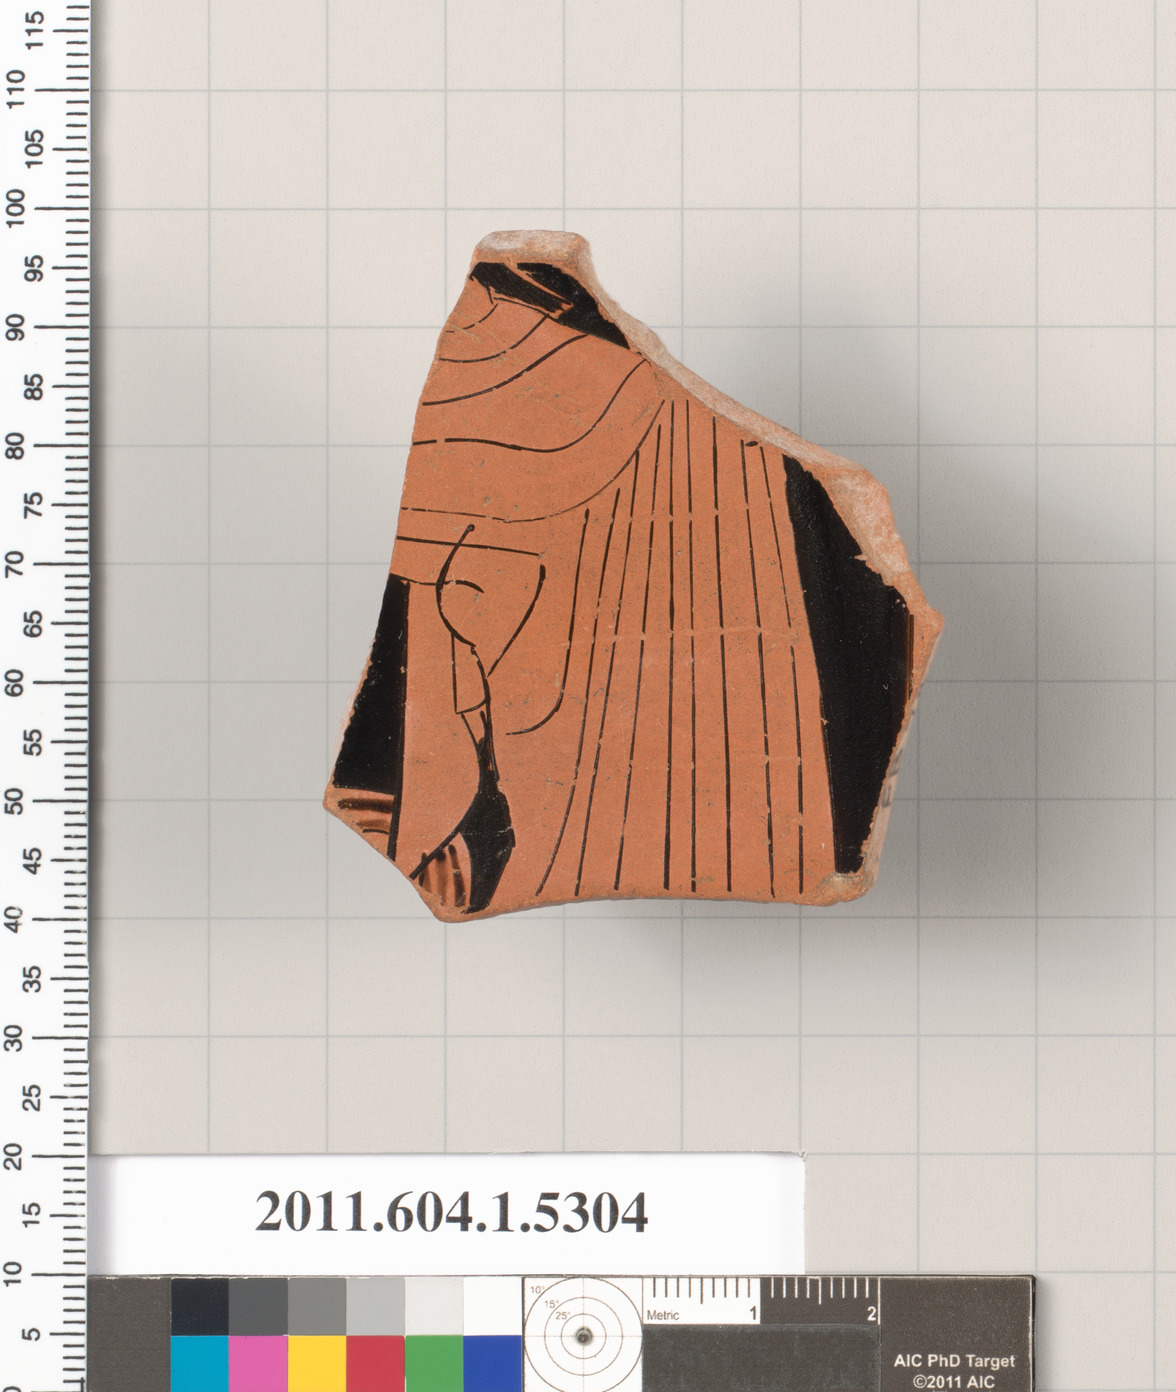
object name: kylix fragment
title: Terracotta fragment of a kylix (drinking cup)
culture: greek, attic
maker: painter of the yale cup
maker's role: artist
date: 475-451 BCE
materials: terracotta